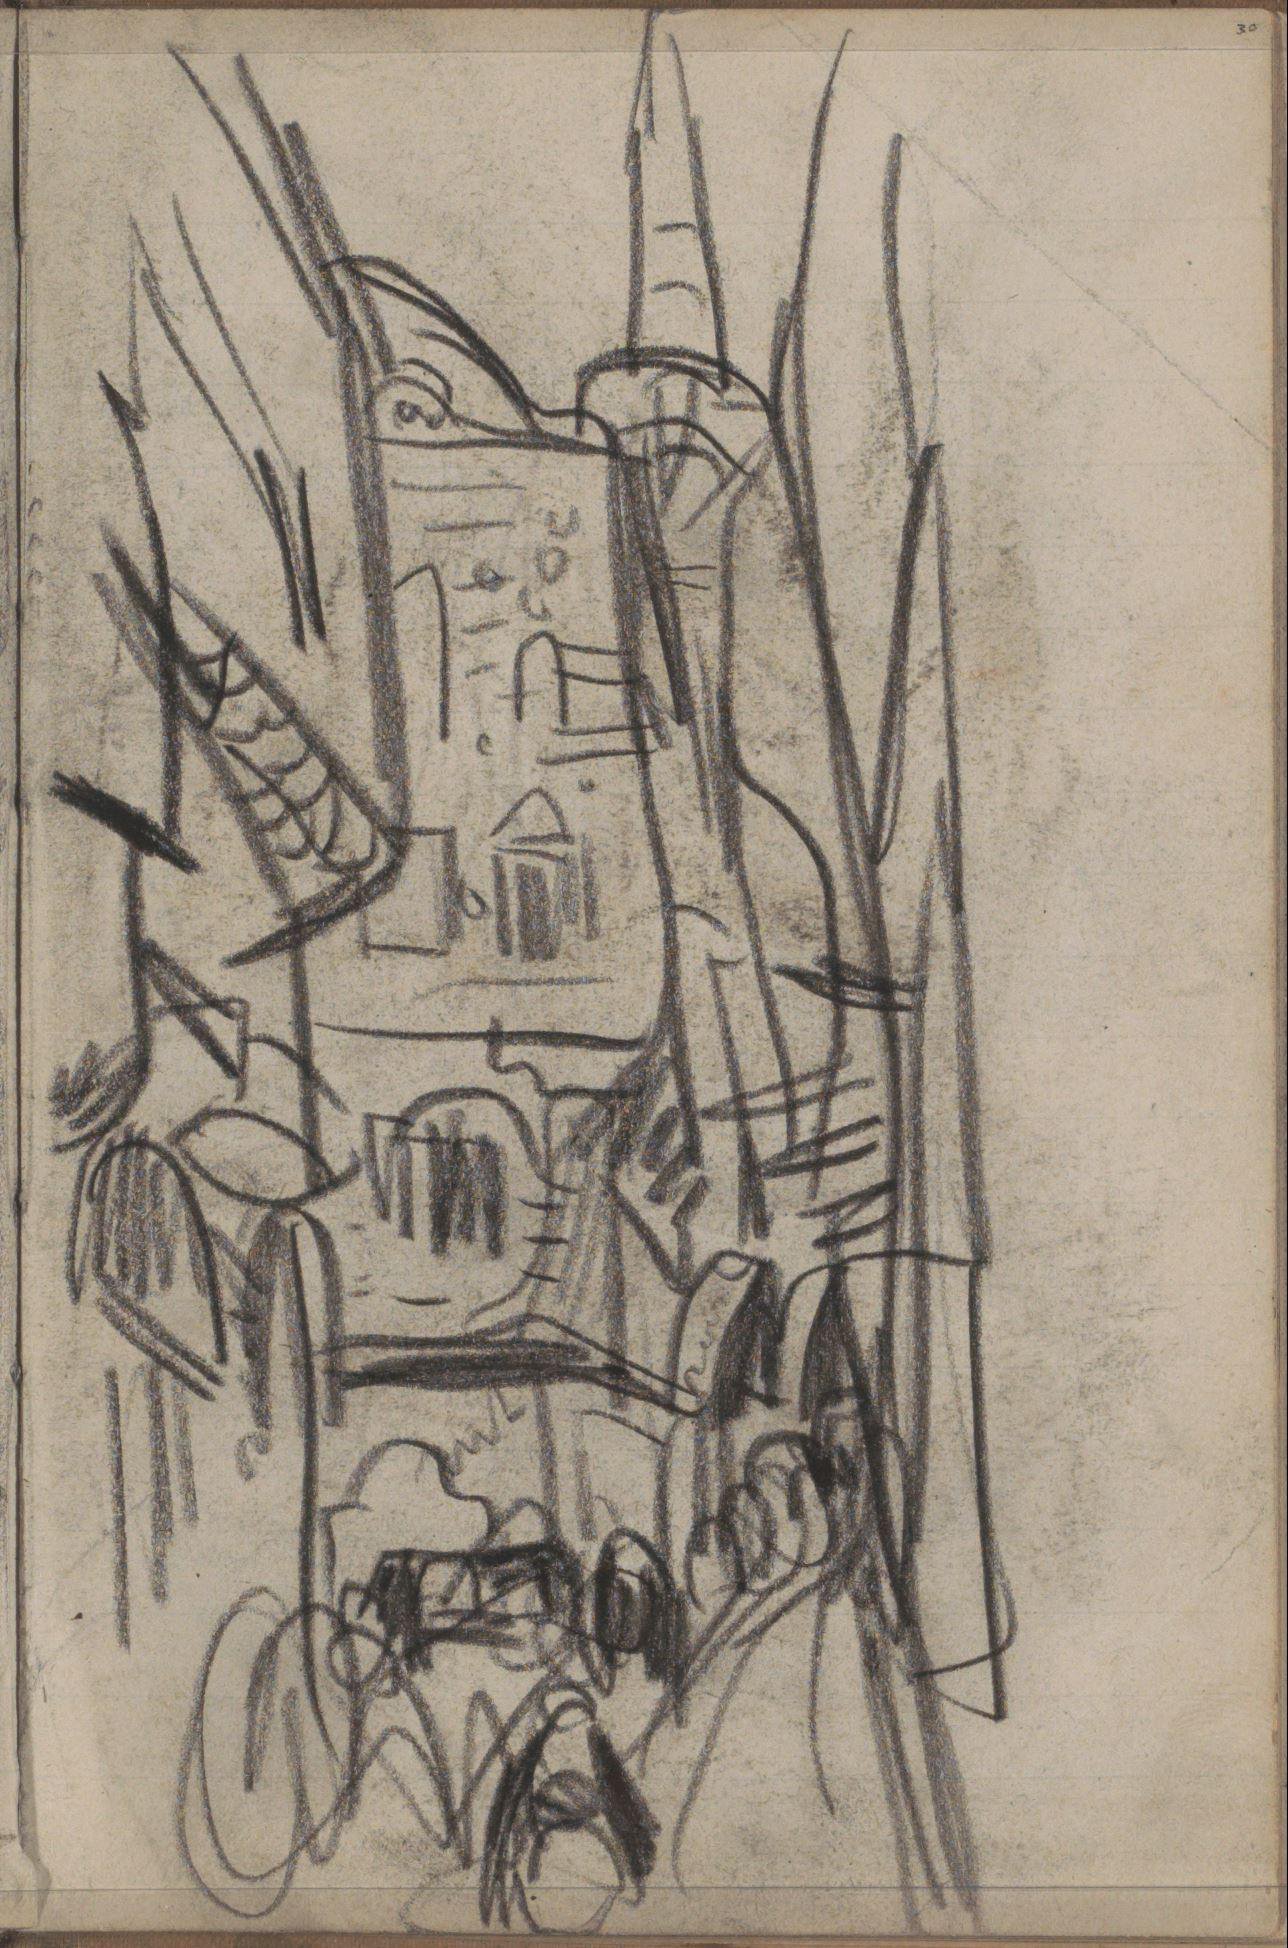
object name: sketchbook leaf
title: Straat met een gebouw met torenspits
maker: marius bauer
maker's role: draughtsman, print maker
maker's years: 1867-1932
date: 1888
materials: chalk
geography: istanbul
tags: spire (of tower on house or building), street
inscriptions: kleurnotitie, handgeschreven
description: Pagina 30 uit een schetsboek met 56 bladen.